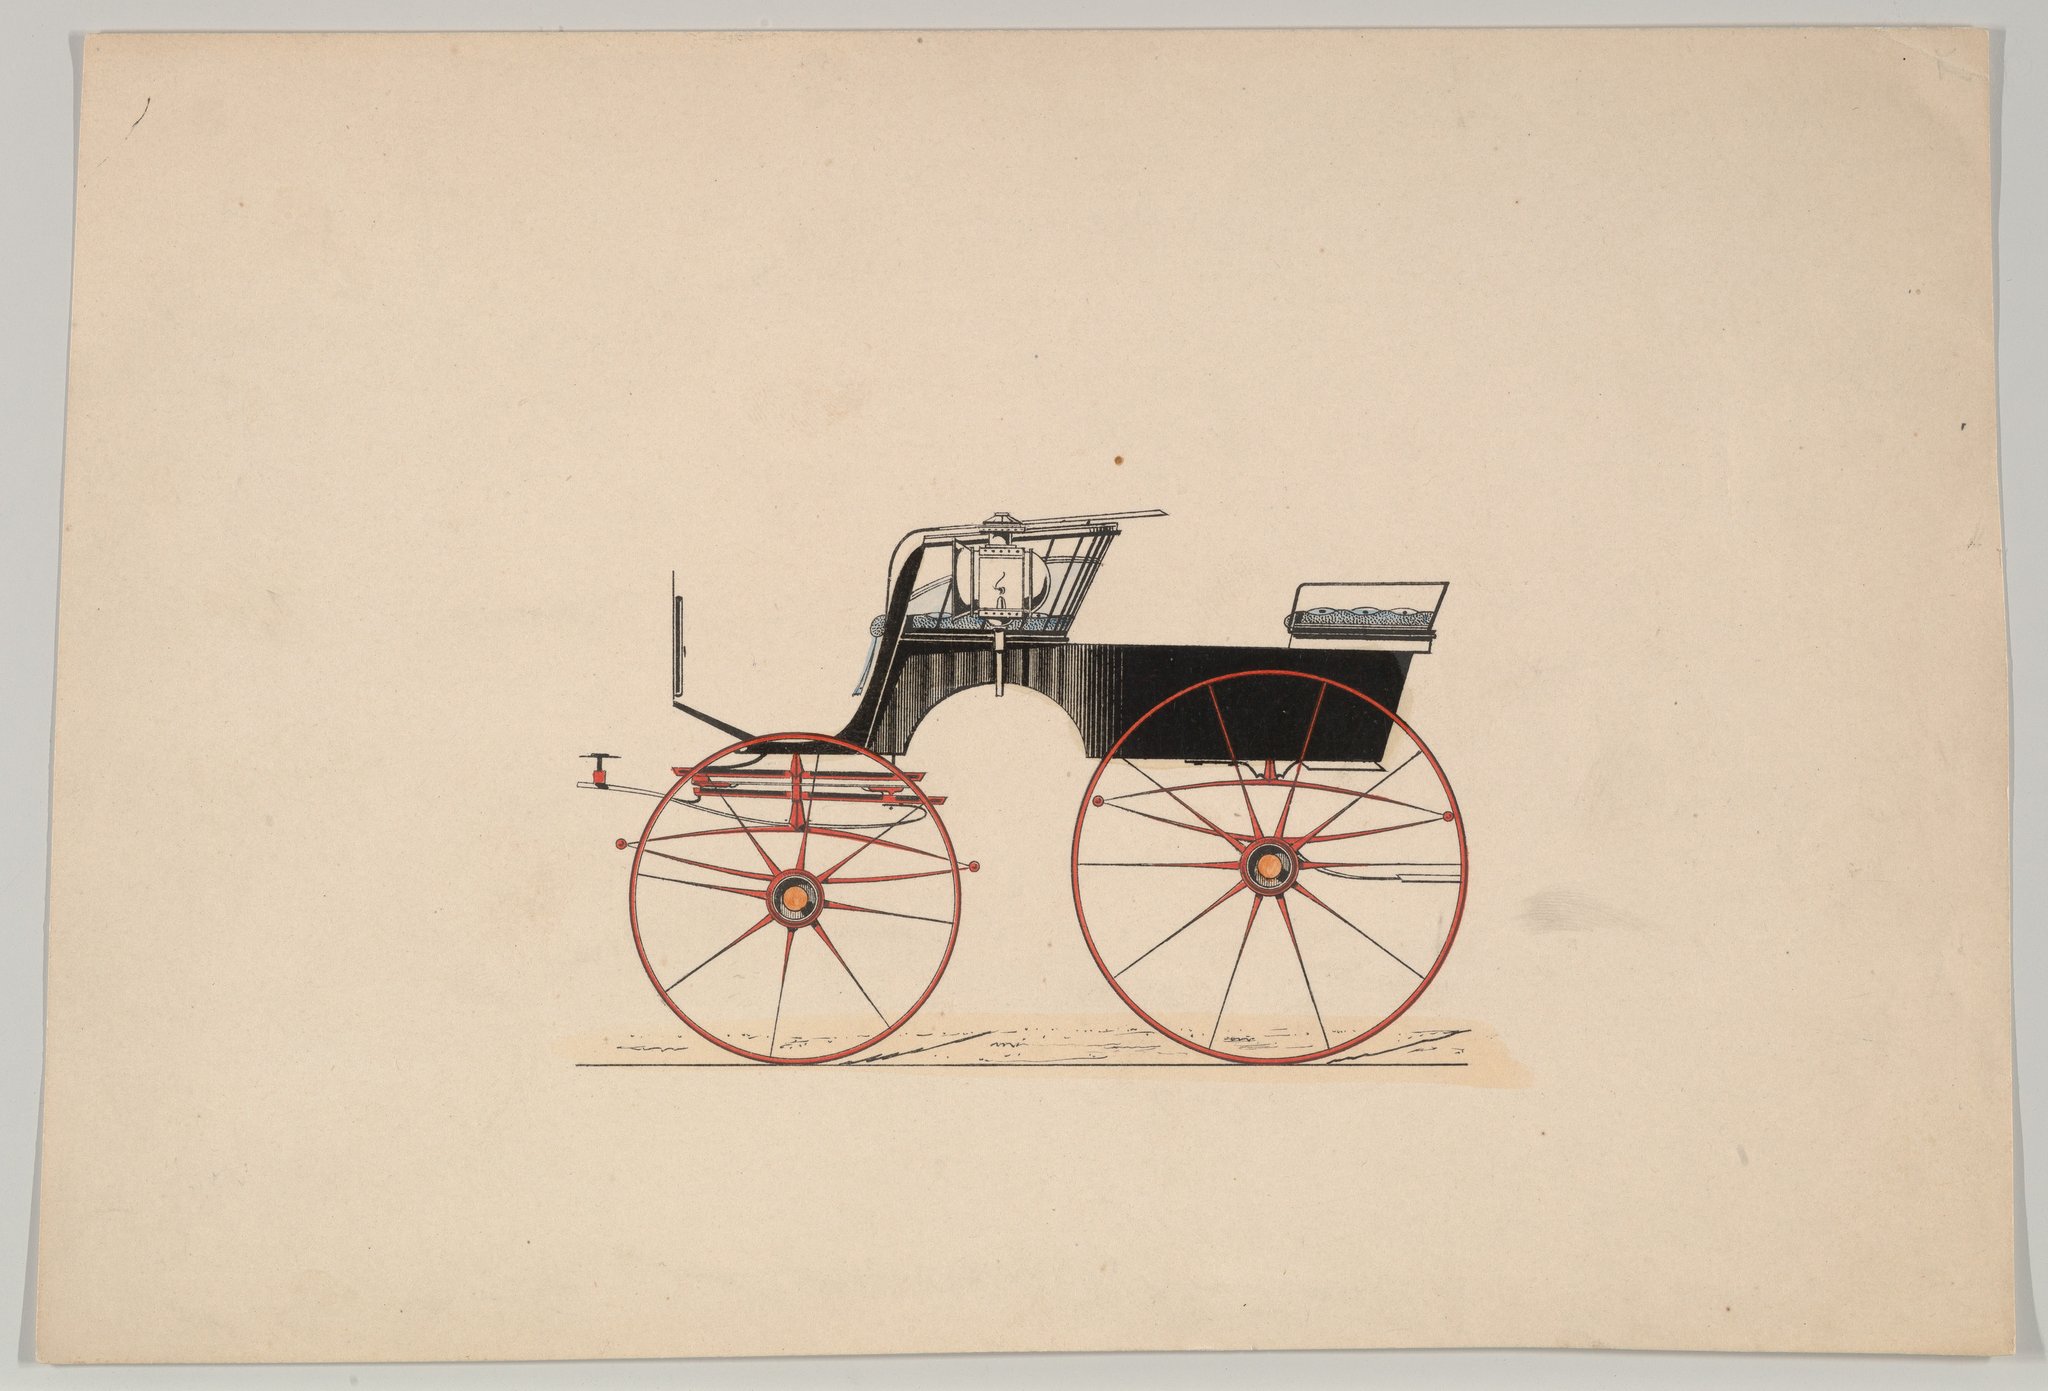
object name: drawing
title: Phaeton (unnumbered)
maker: brewster & co.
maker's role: manufacturer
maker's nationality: american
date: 1850-1870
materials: gouache, ink, watercolor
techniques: pen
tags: carriages